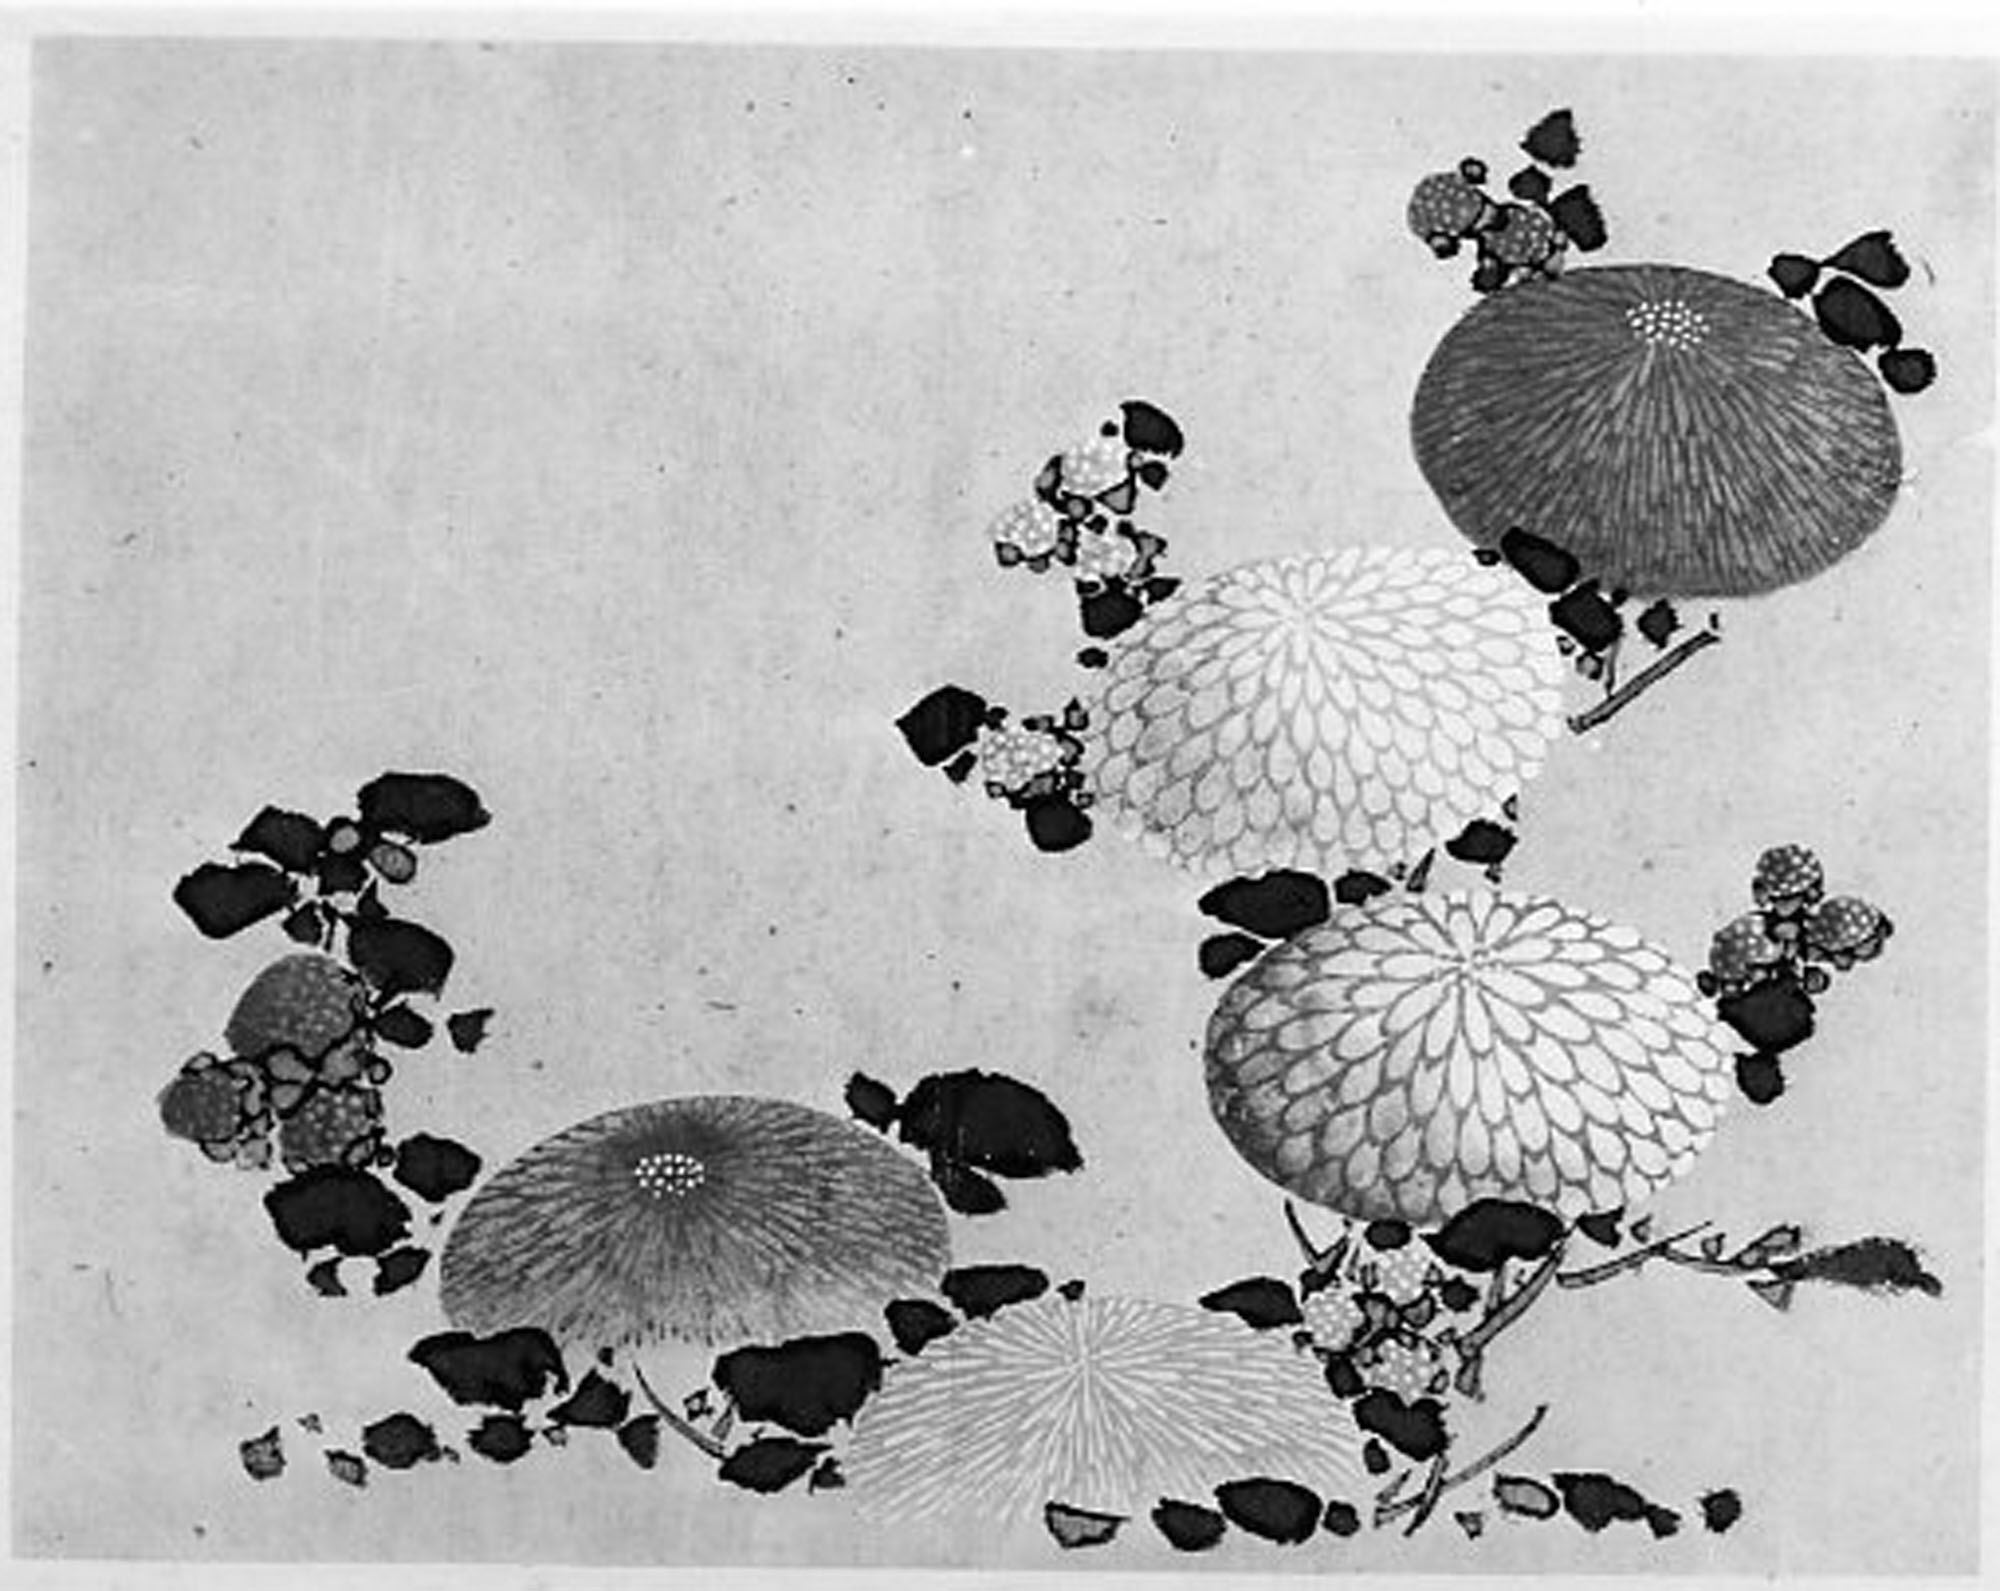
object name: painting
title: Chrysanthemums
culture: japanese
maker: hokusai school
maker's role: artist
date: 1801-1900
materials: paper, watercolor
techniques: painting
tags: flowers